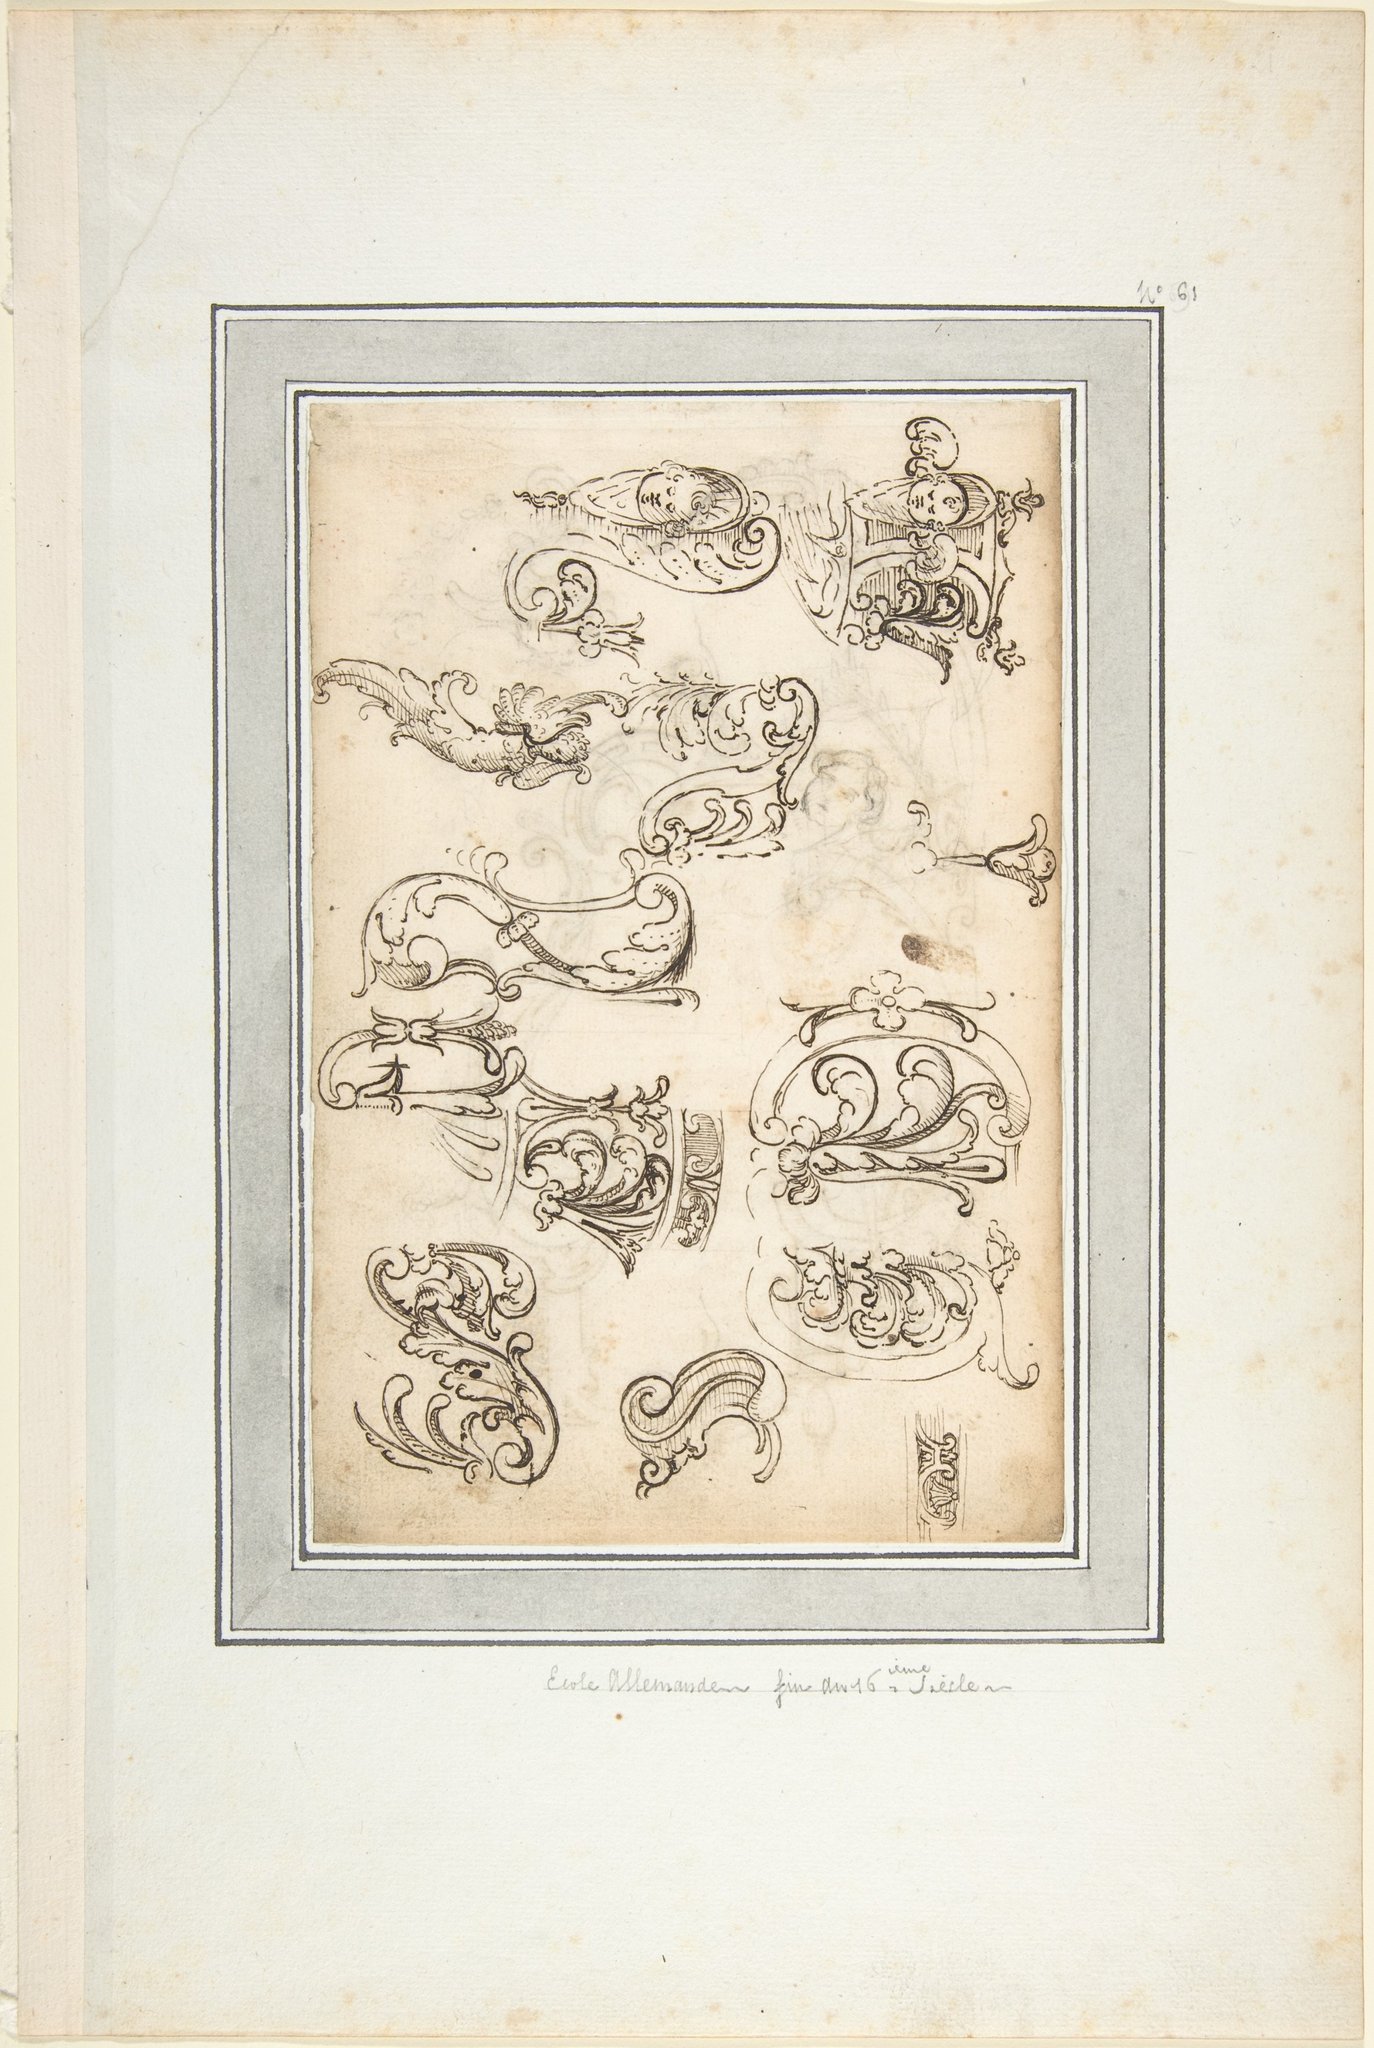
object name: drawing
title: Various Ornamental Designs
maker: anonymous, german, 19th century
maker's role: artist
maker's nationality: german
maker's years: 1800-1899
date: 1801-1900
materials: chalk, ink, paper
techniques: inlay, pen, wash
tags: ornament,faces